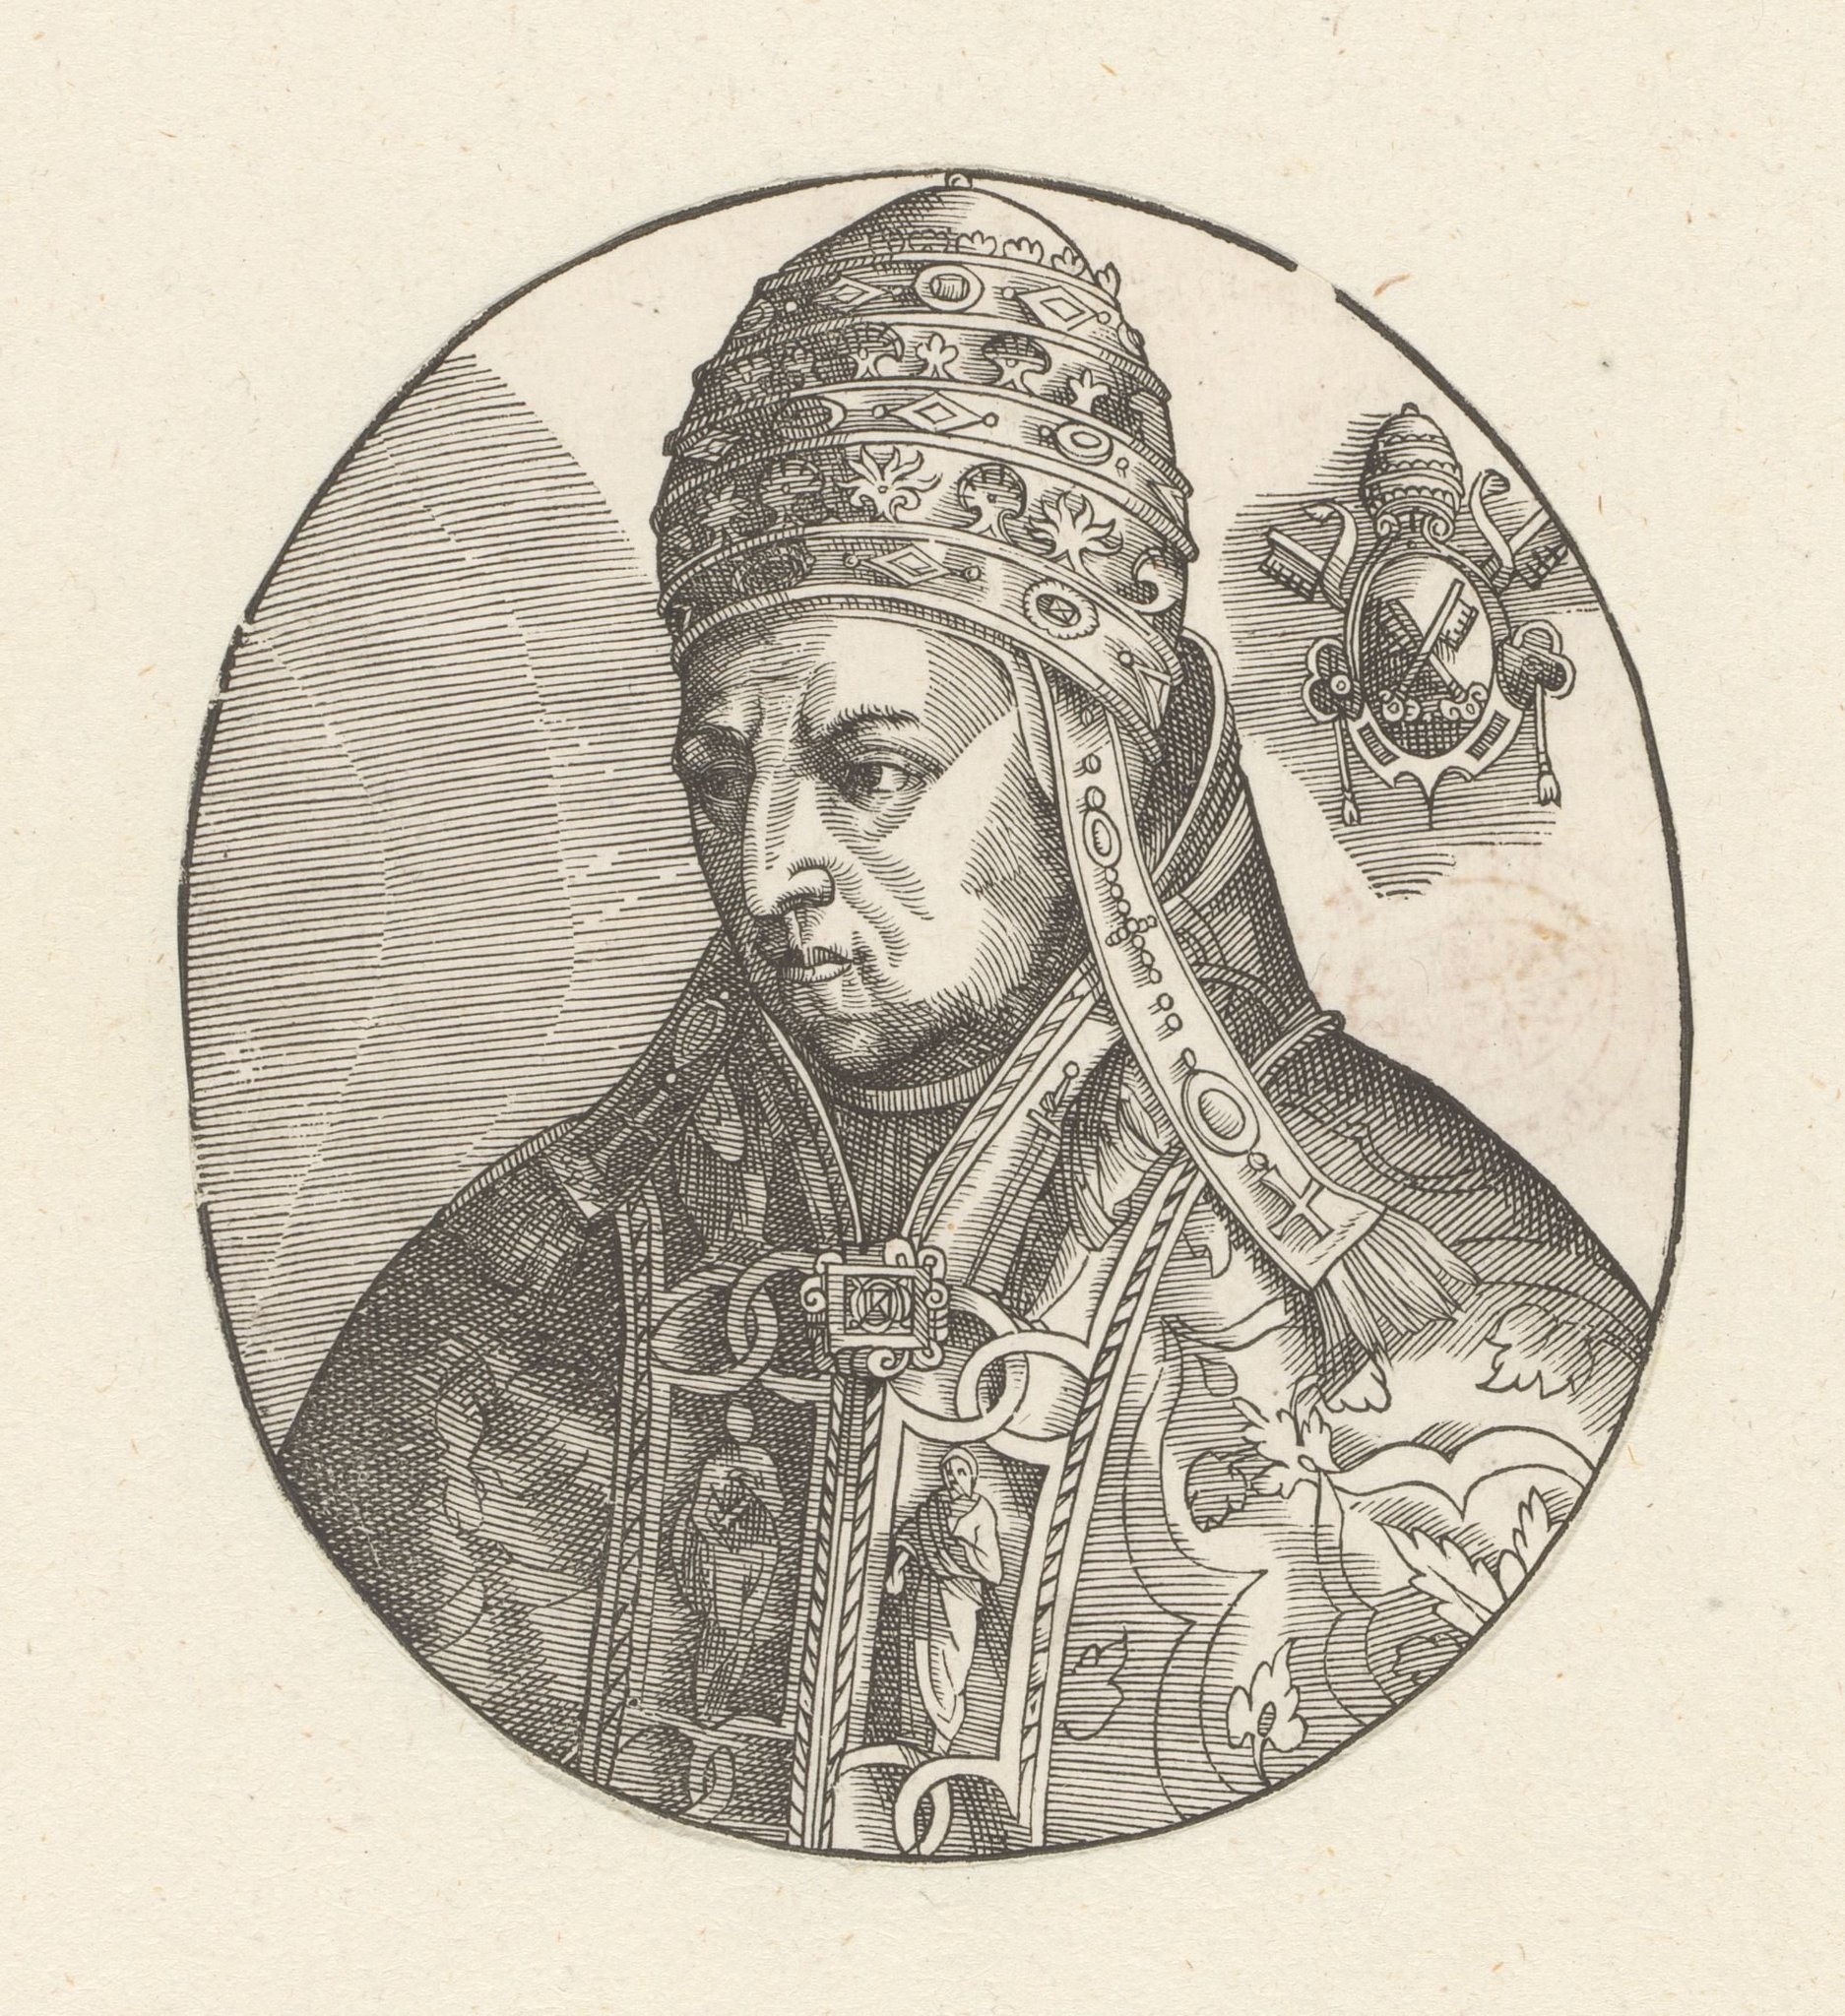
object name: print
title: Portret van paus Nicolaas V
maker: Anonymous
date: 1549-1573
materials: paper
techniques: woodcut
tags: rome, historical persons, pope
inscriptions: collector's mark: Lugt 240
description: Prent gebruikt in: Panvinio, Onofrio. Accuratae Effigies Pontificum (...). Straatsburg: Bernhard Jobin, 1573.